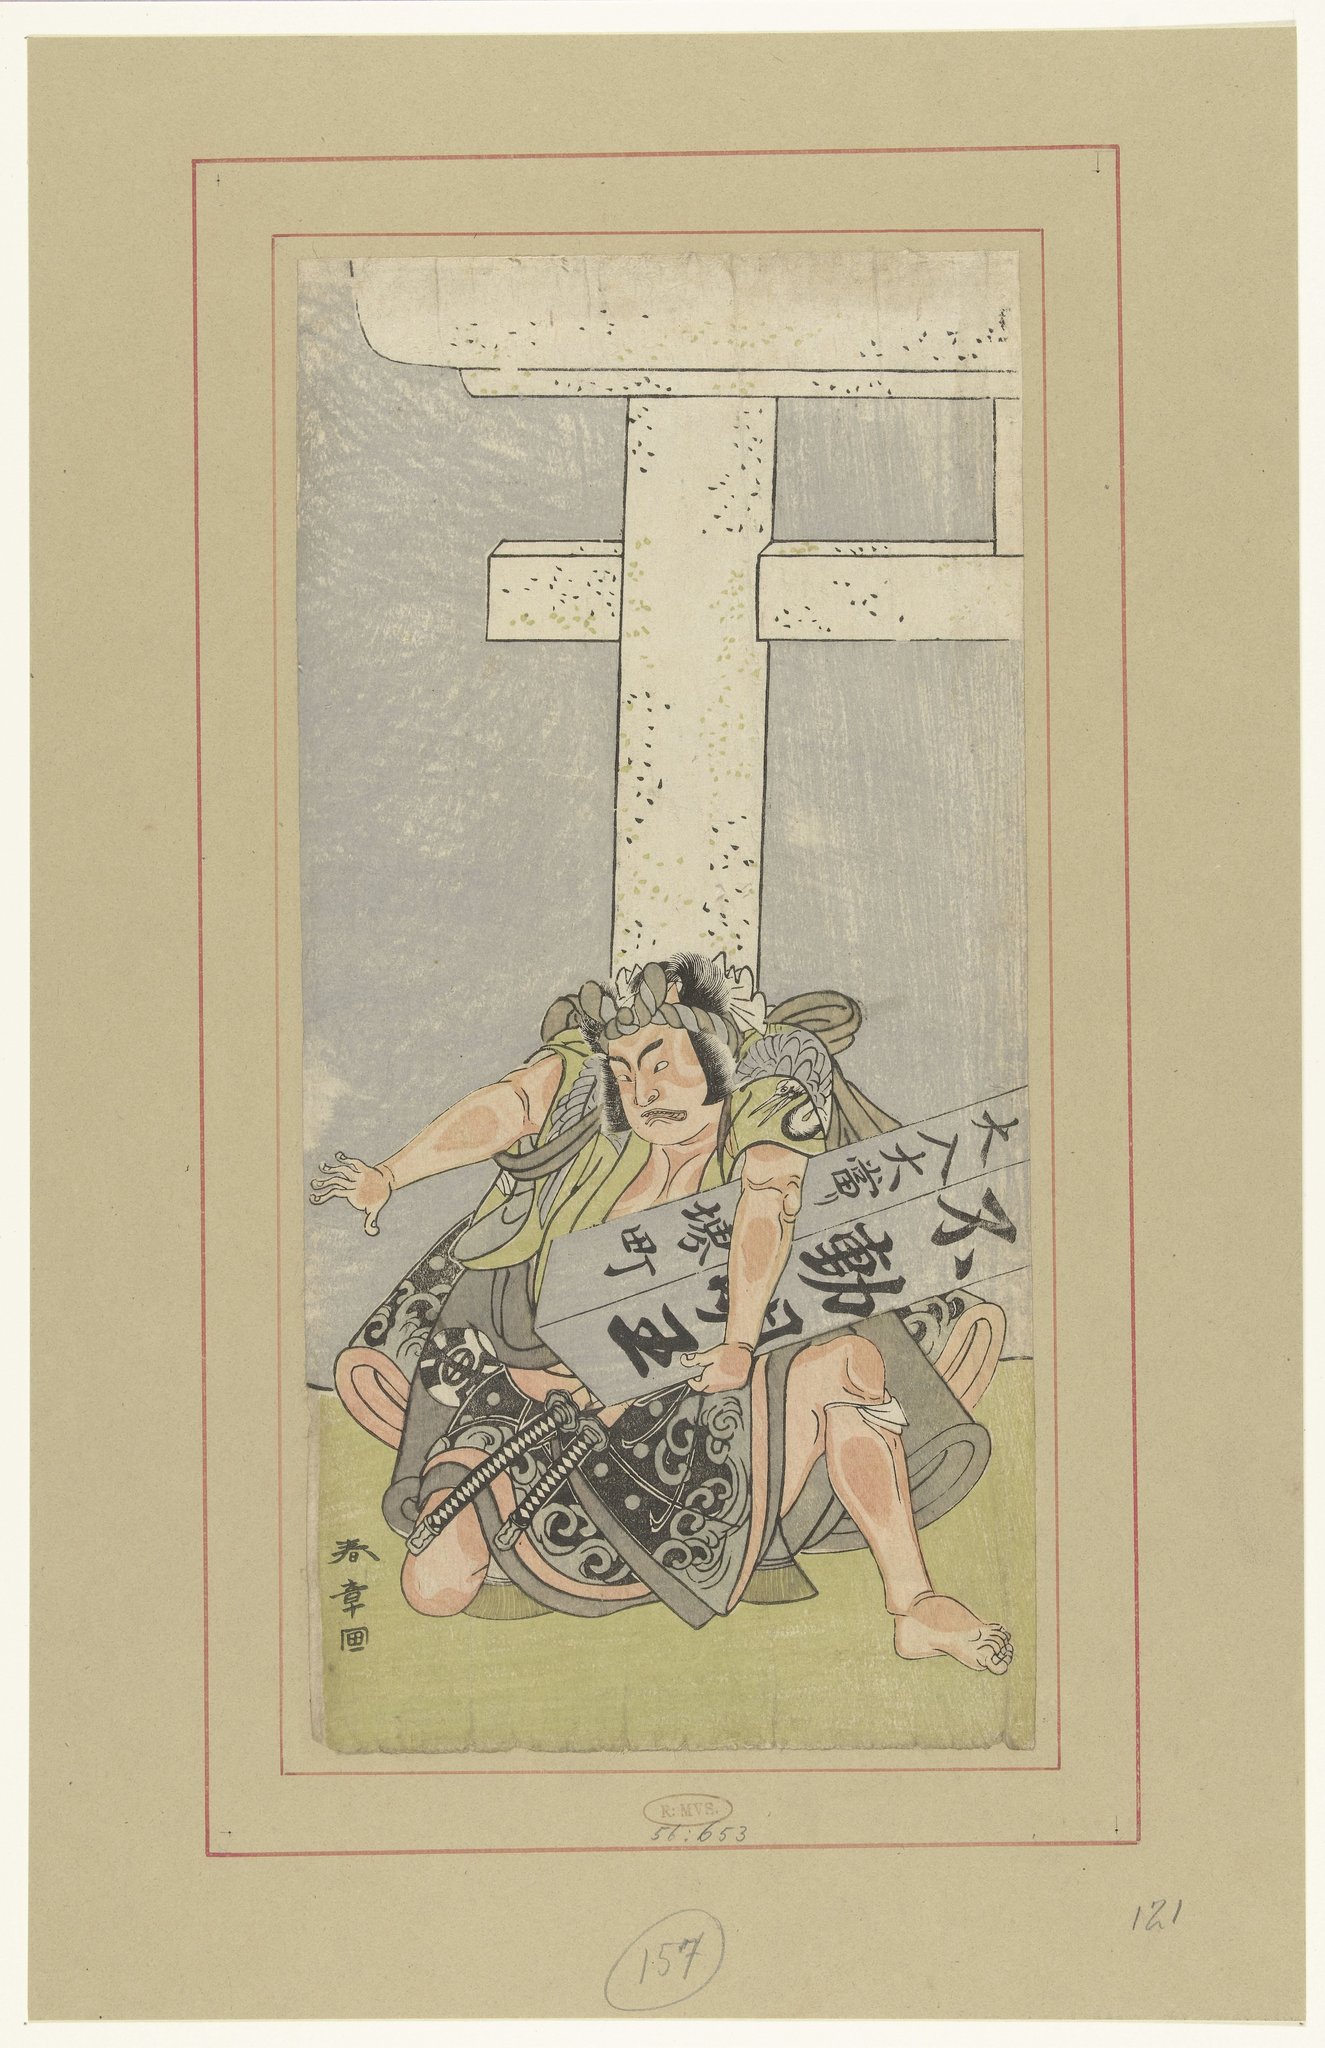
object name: print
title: Acteur Nakamura Nakazo I een pilaar optillend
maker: katsukawa shunsho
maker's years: 1726-1792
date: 1773-1777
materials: paper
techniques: woodcut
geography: japan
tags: column, pillar ~ architecture, portrait of actor, actress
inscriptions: collector's mark: Lugt 2228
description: De acteur Nakamura Nakazo I in de rol van samoerai, op één knie, met de linker arm een stenen pilaar vasthoudend; een stenen torii op de achtergrond. Op de pilaar de naam van de Boeddhistische god Fudo Myoo. Linker blad van een diptiek.